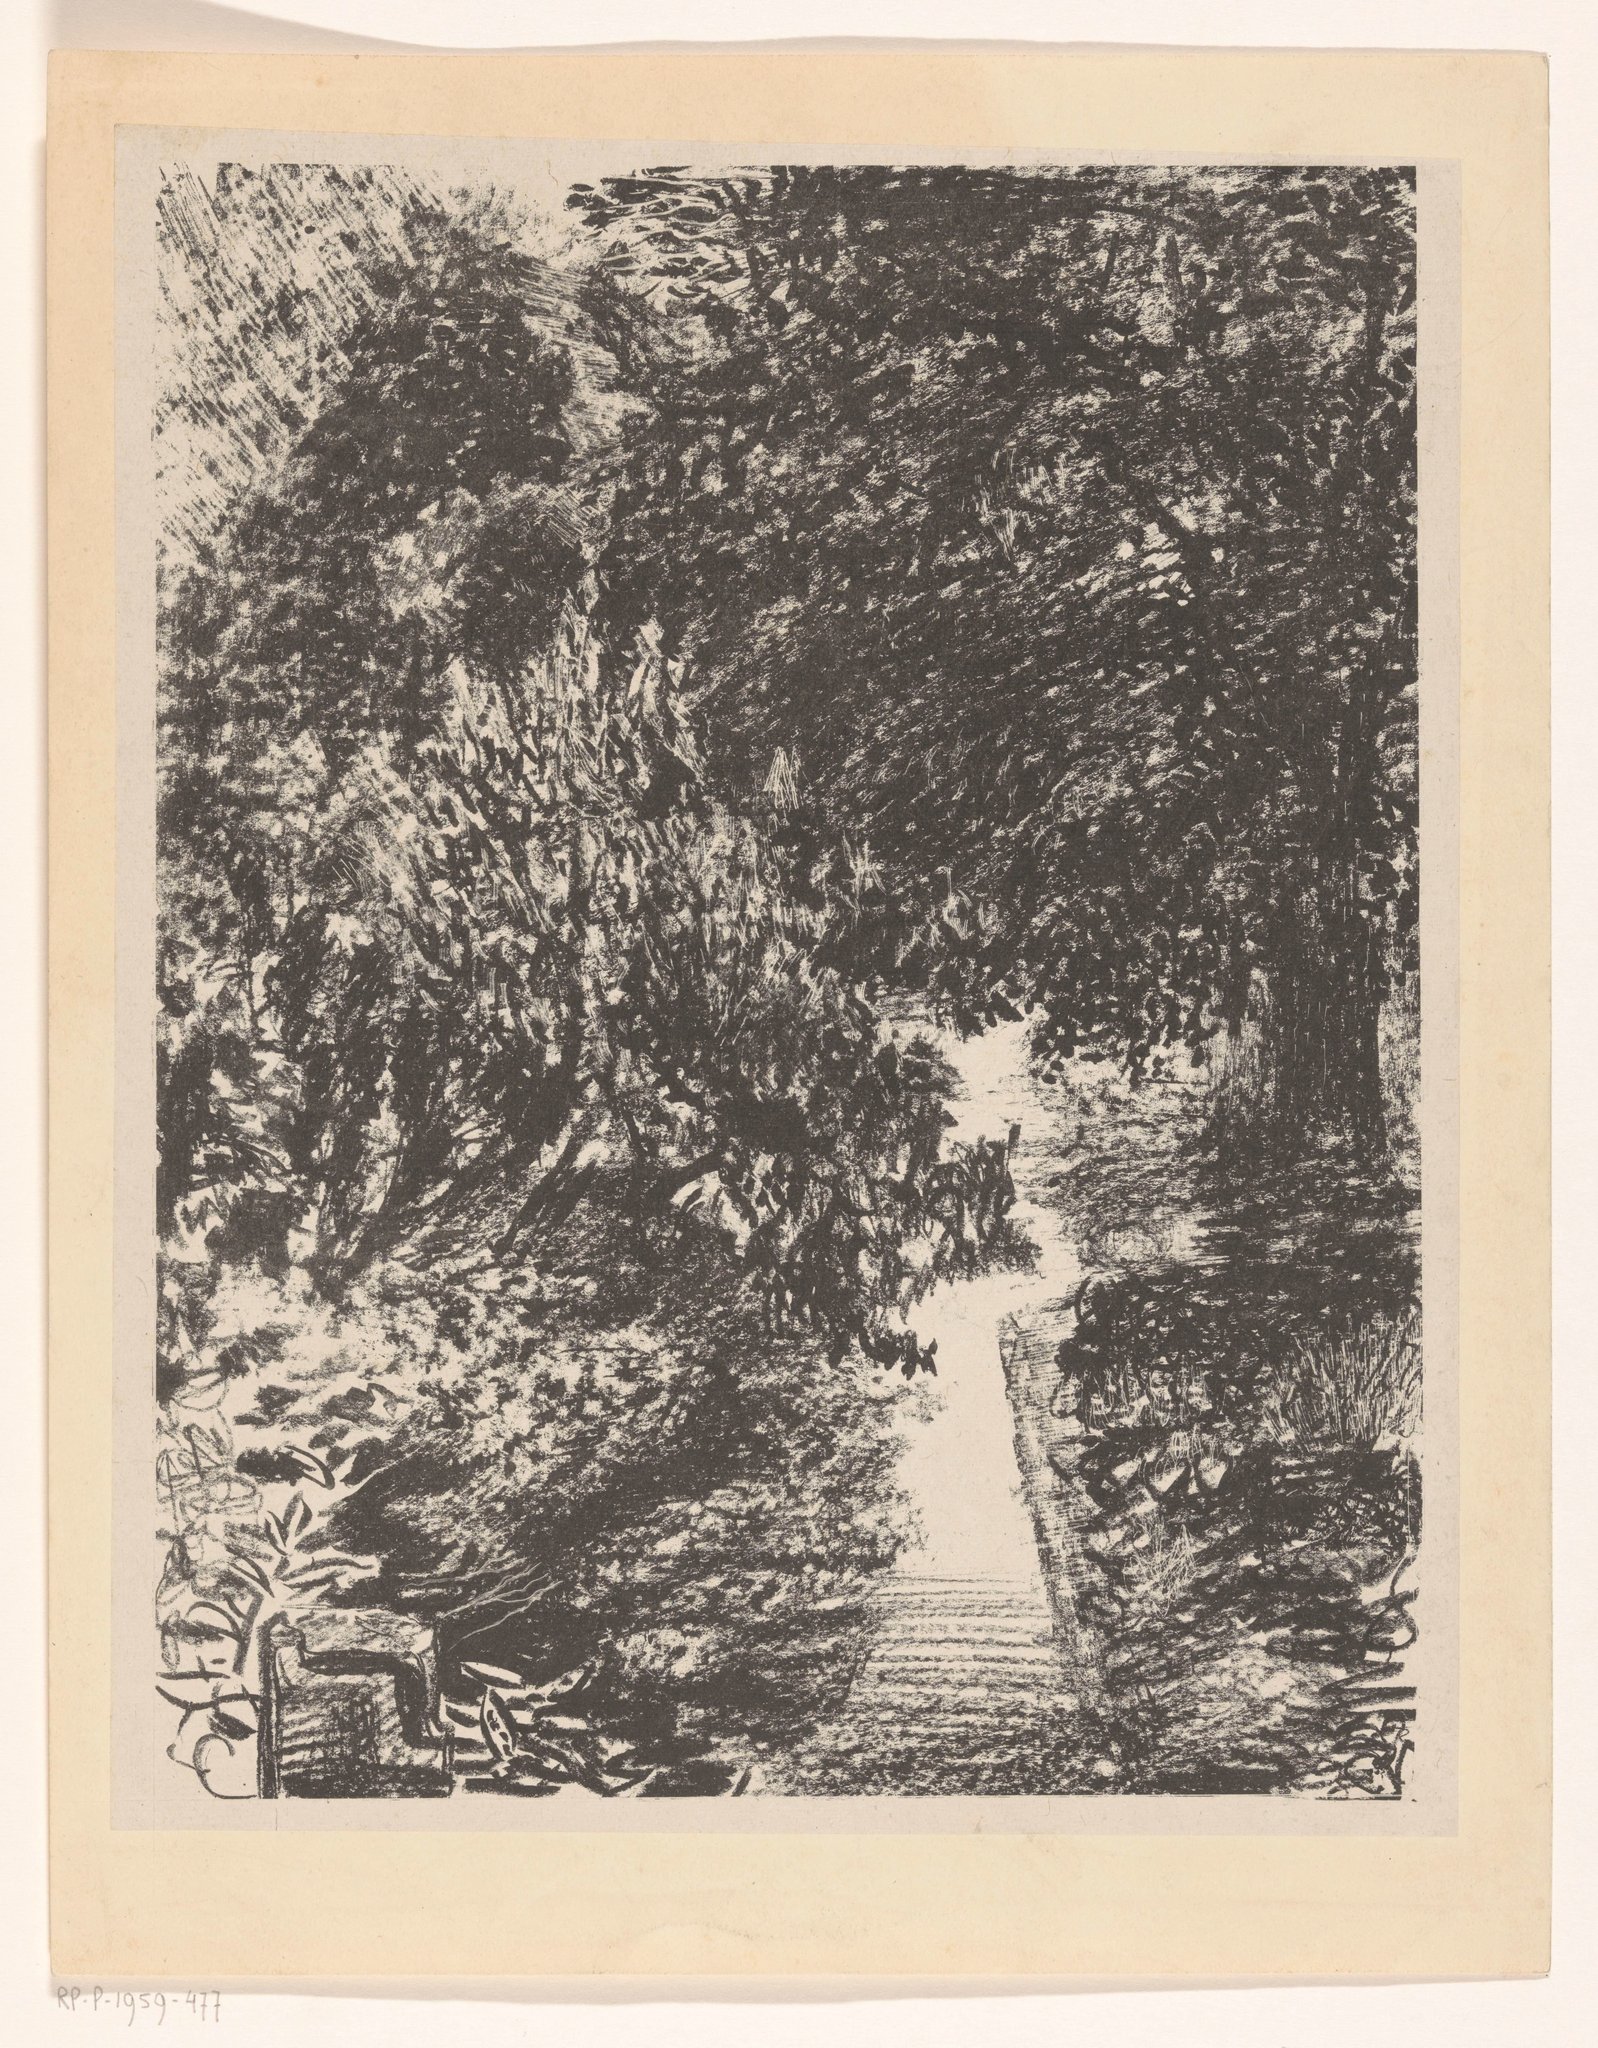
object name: print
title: Tuinpad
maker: carel adolph lion cachet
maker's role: draughtsman, print maker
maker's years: 1864-1945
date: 1874-1945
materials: paper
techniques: lithograph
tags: garden, road, path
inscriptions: collector's mark: Lugt 2228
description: Mogelijk de tuin van Lion Cachets woning in Vreeland, huize Schoonoord.